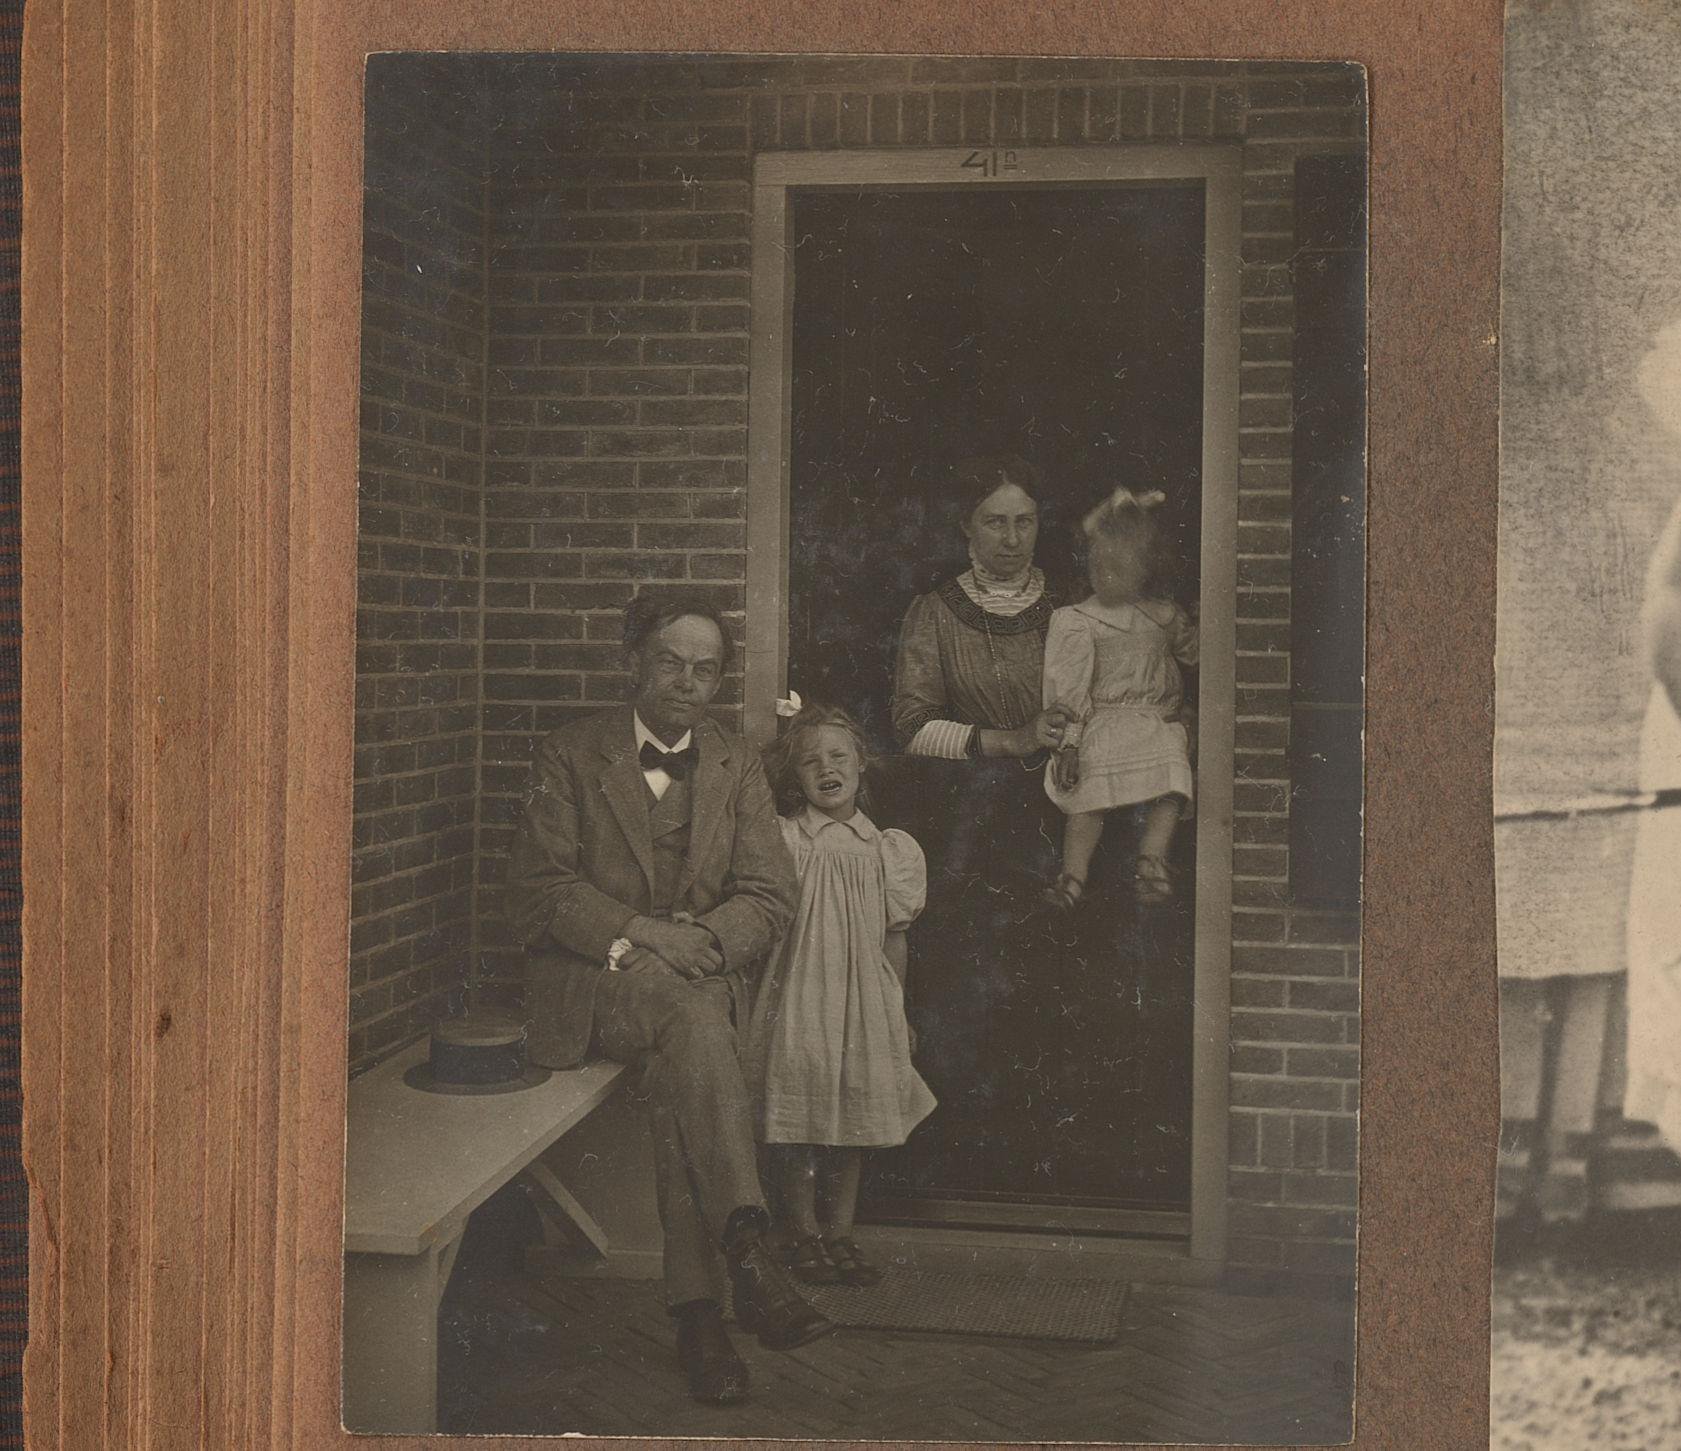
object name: photograph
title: Alphonse Diepenbrock met zijn gezin voor de Holtwiek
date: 1911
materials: photographic support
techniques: photography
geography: amsterdam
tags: alphons diepenbrock, netherlands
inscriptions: inscription: ‘Holtwiek . 1911.’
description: Foto op bruin albumblad 28 van familiealbum van Alphons Diepenbrock.